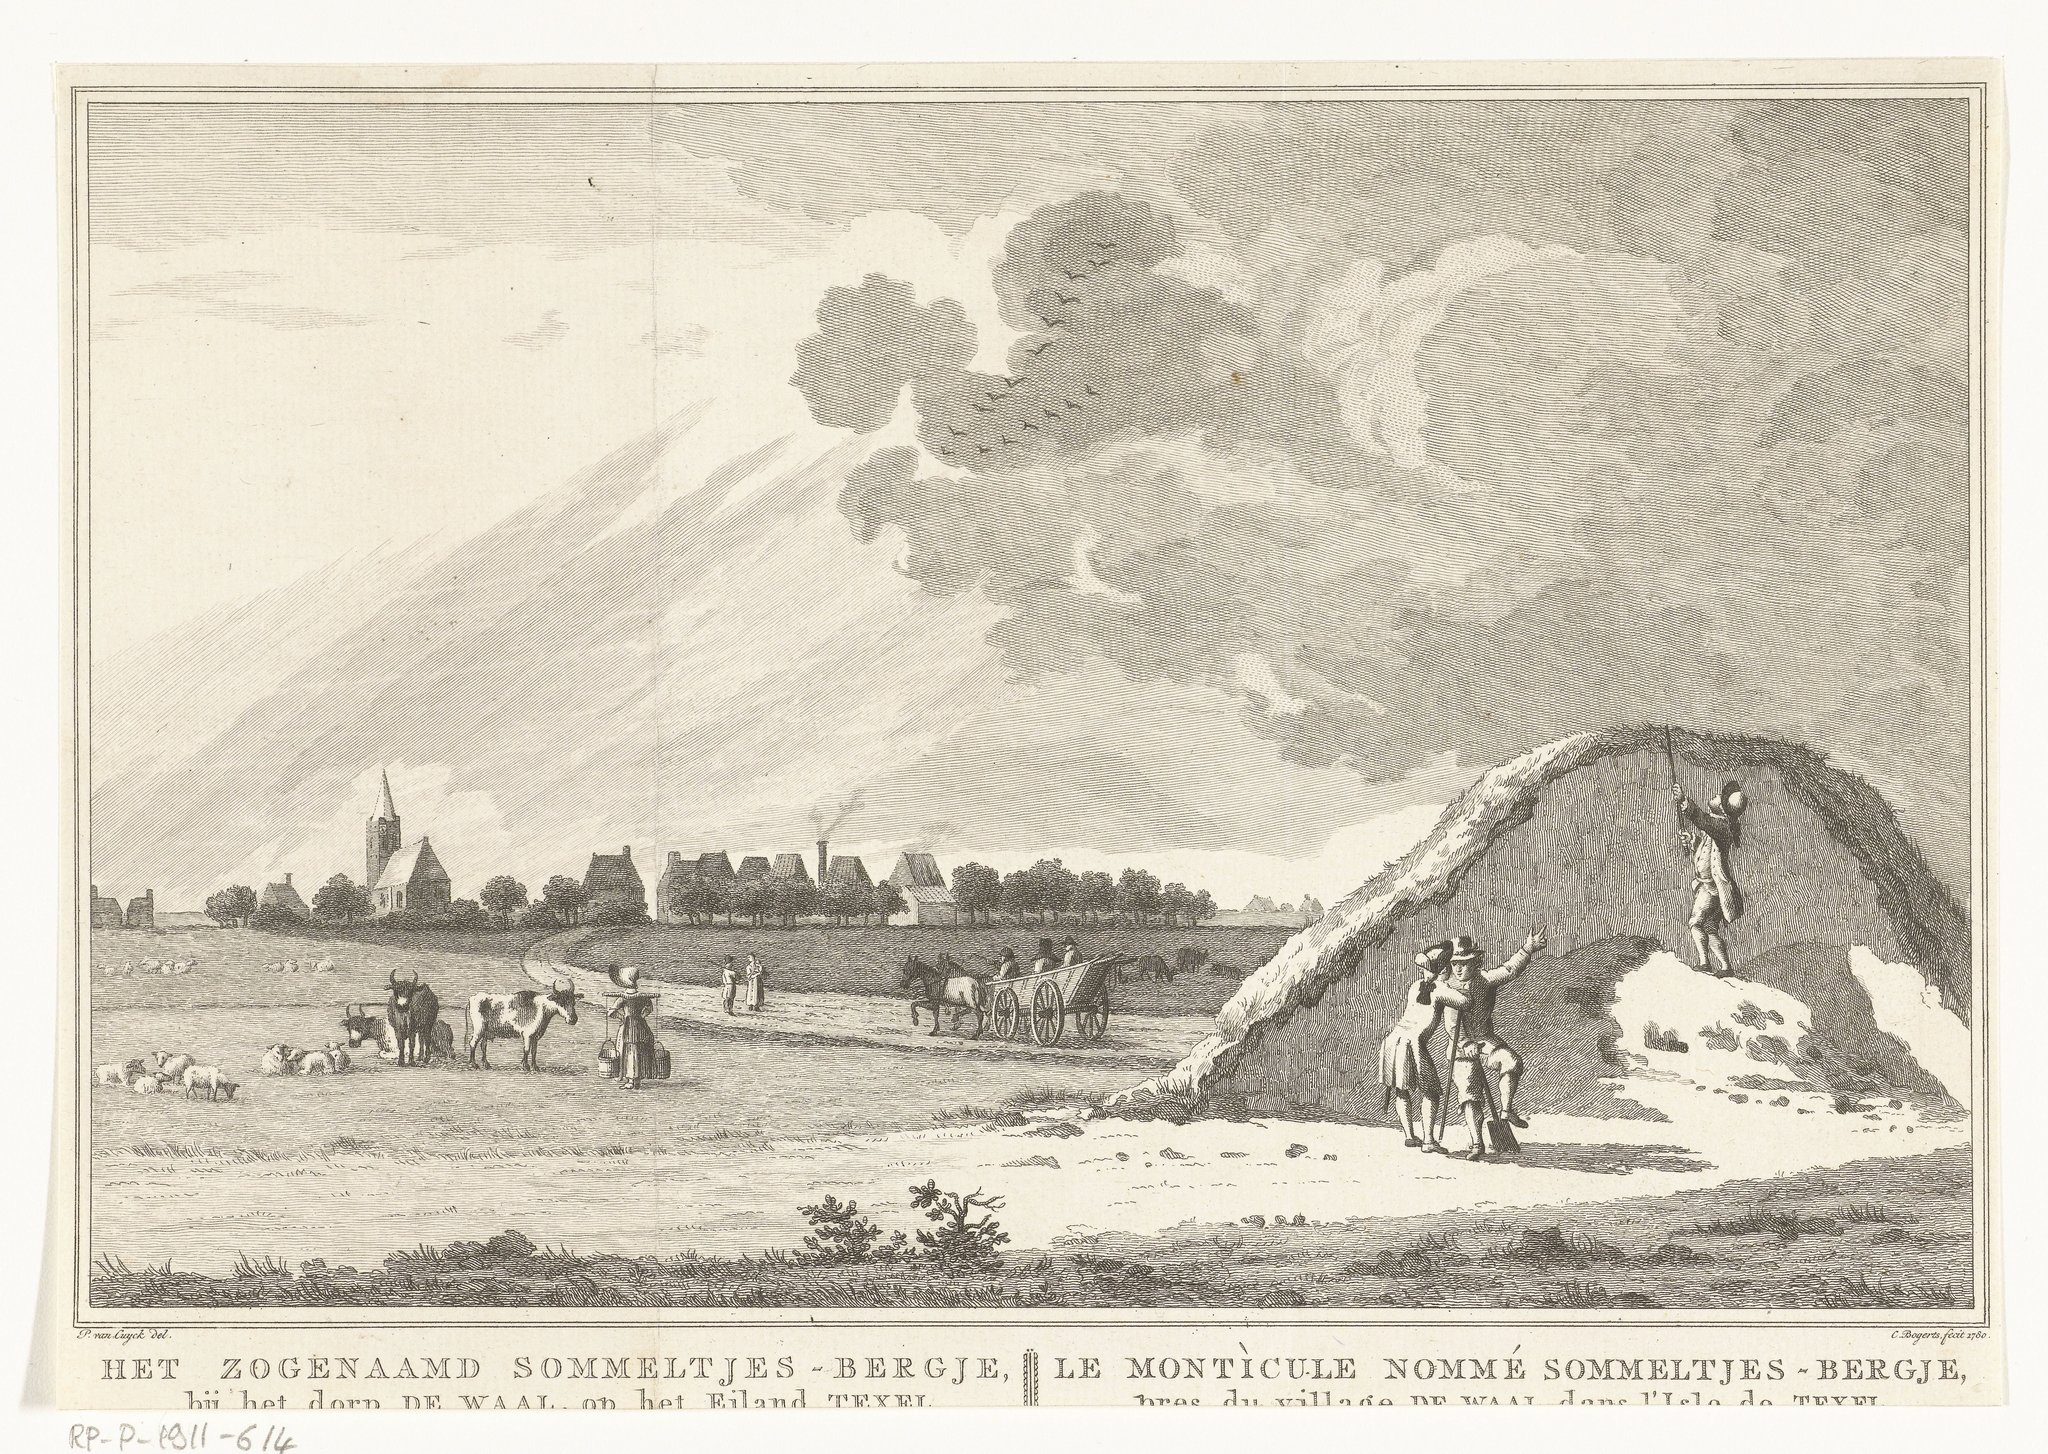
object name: print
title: Sommeltjesbergje op Texel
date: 1777-1779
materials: paper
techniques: etching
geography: amsterdam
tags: fabulous animals (sometimes wrongly called 'grotesques'); 'mostri' (ripa)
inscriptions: collector's mark: Lugt 2228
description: Gezicht op een dorp op Texel. Langs de weg naar het dorp staat een half afgedragen heuvel, de zogenaamde Sommeltjesberg. Een man is bezig de binnenkant van de heuvel te onderzoeken. Twee gravers staan naast de heuvel te wachten. Het verhaal gaat dat in deze berg de Sommeltjes woonden. Kleine wezens die 's-nachts uit de berg komen en goede daden op het eiland verrichten.